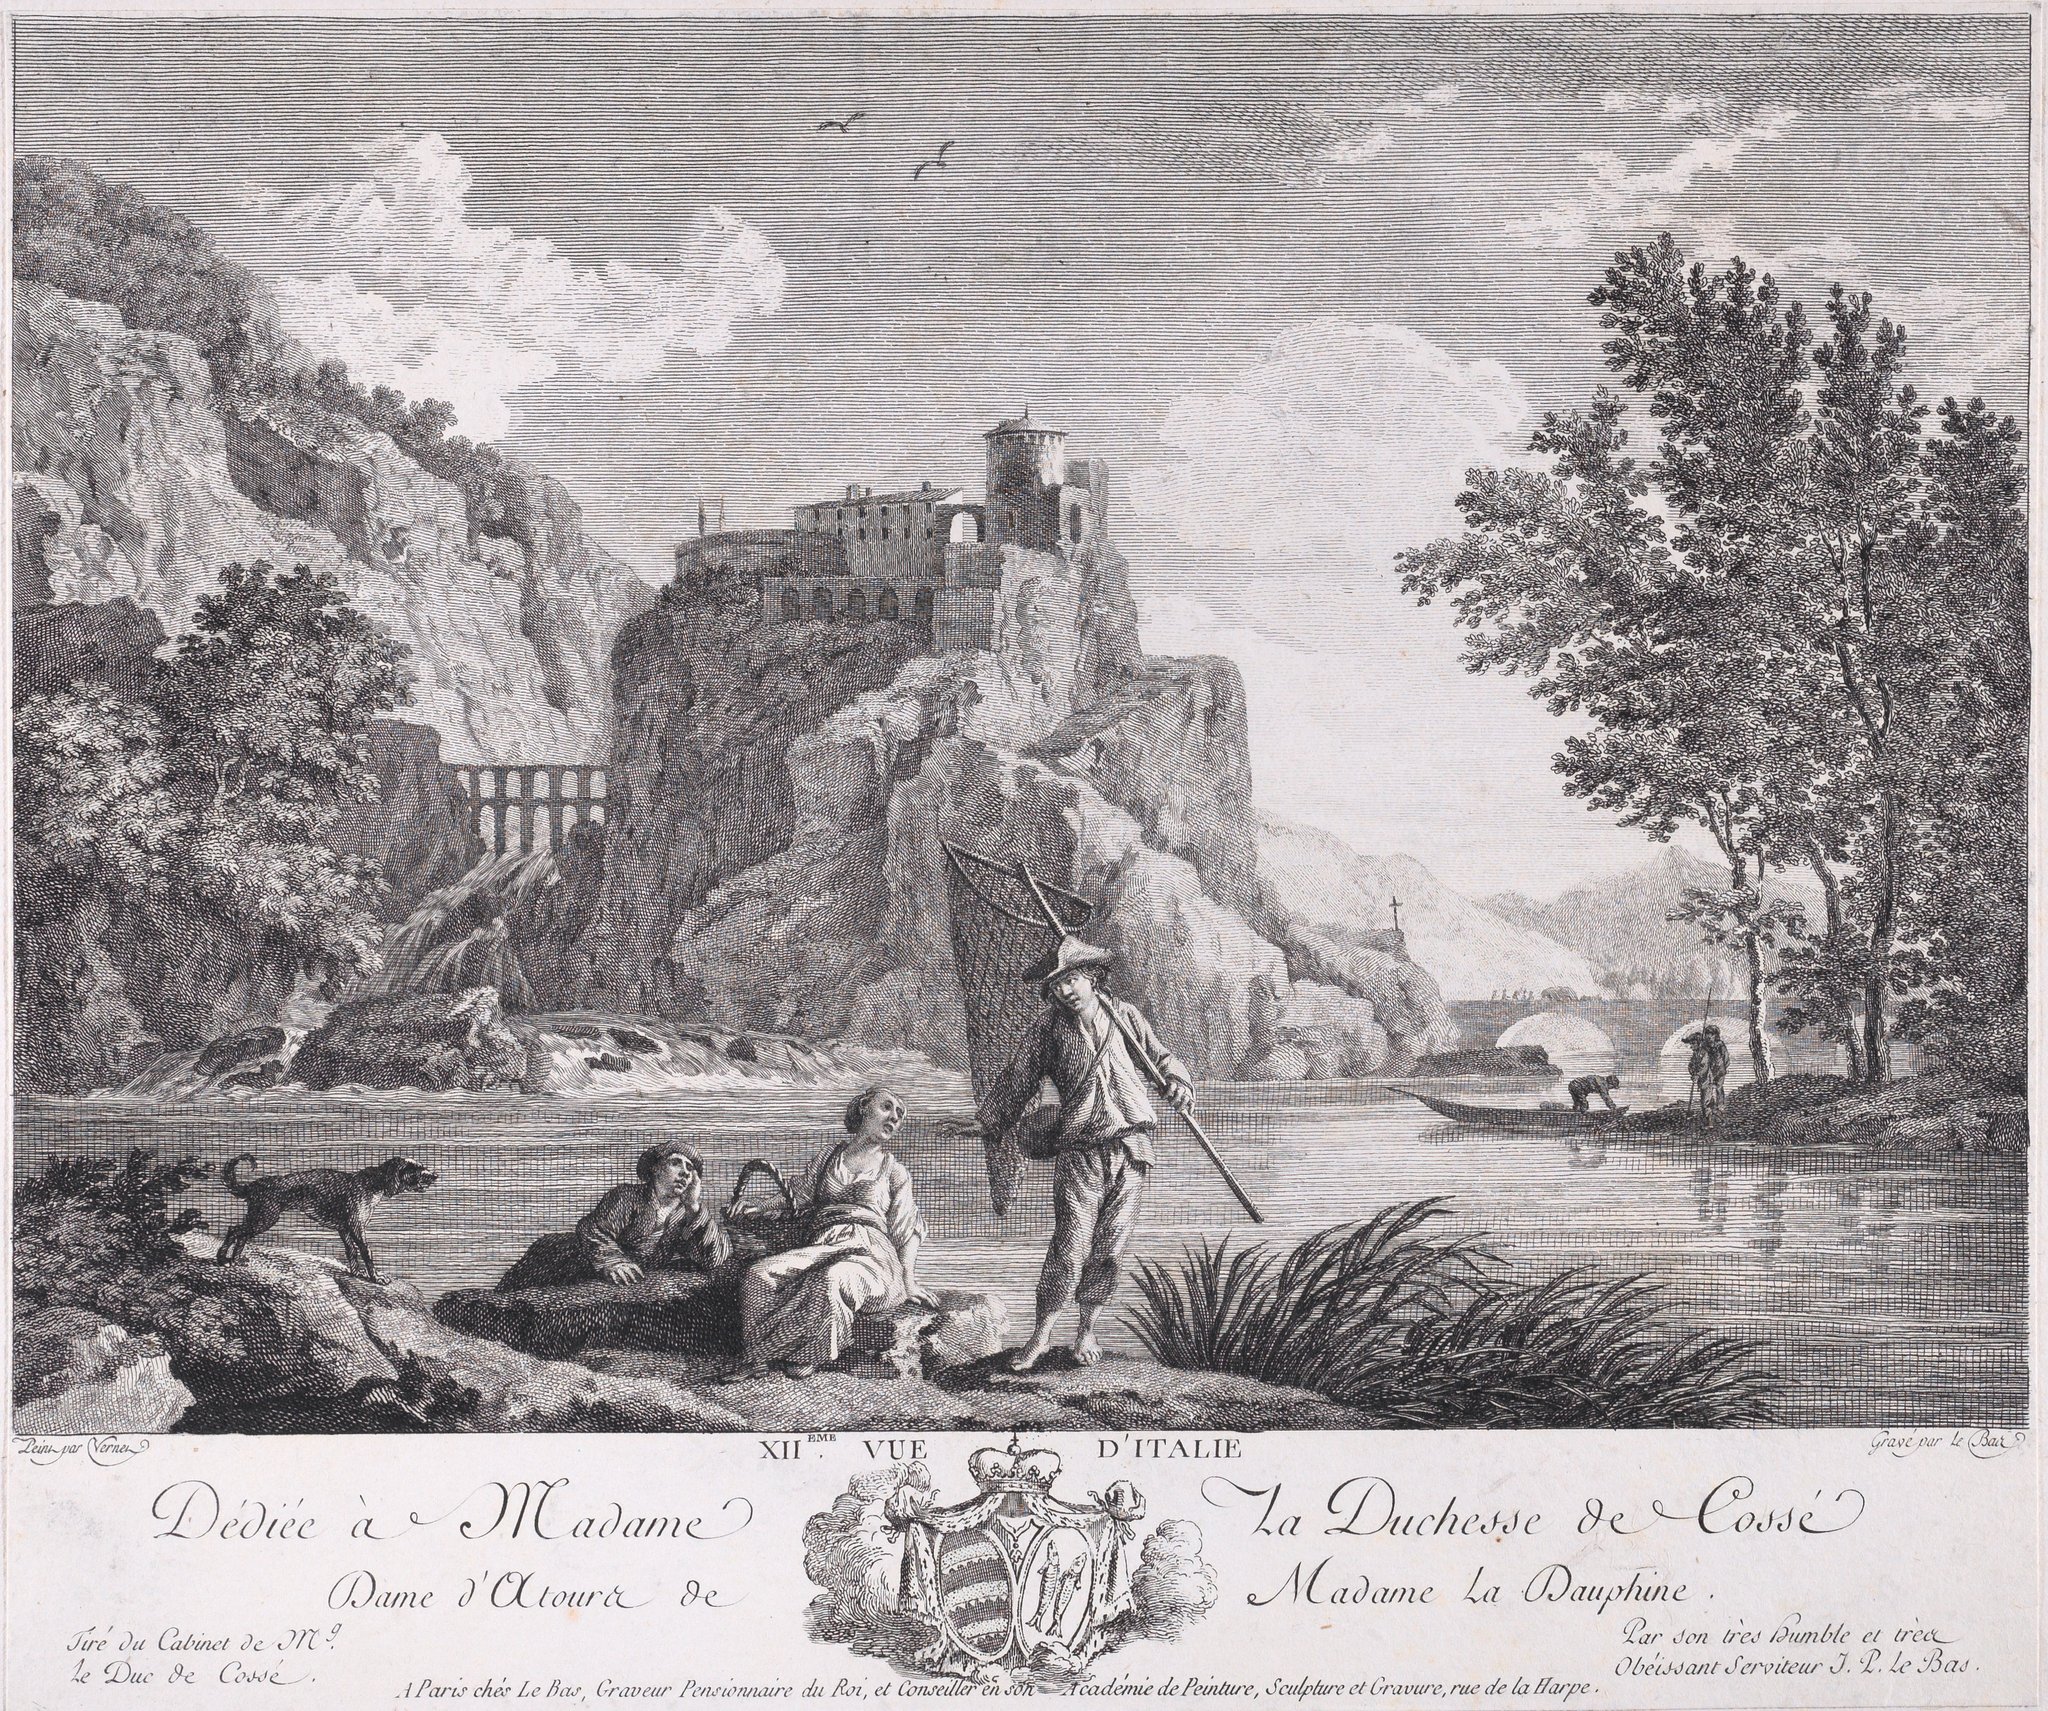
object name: print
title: XIIeme Vue d'Italie. Le Bas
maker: joseph vernet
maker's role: artist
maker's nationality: french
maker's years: 1714-1789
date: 1701-1800